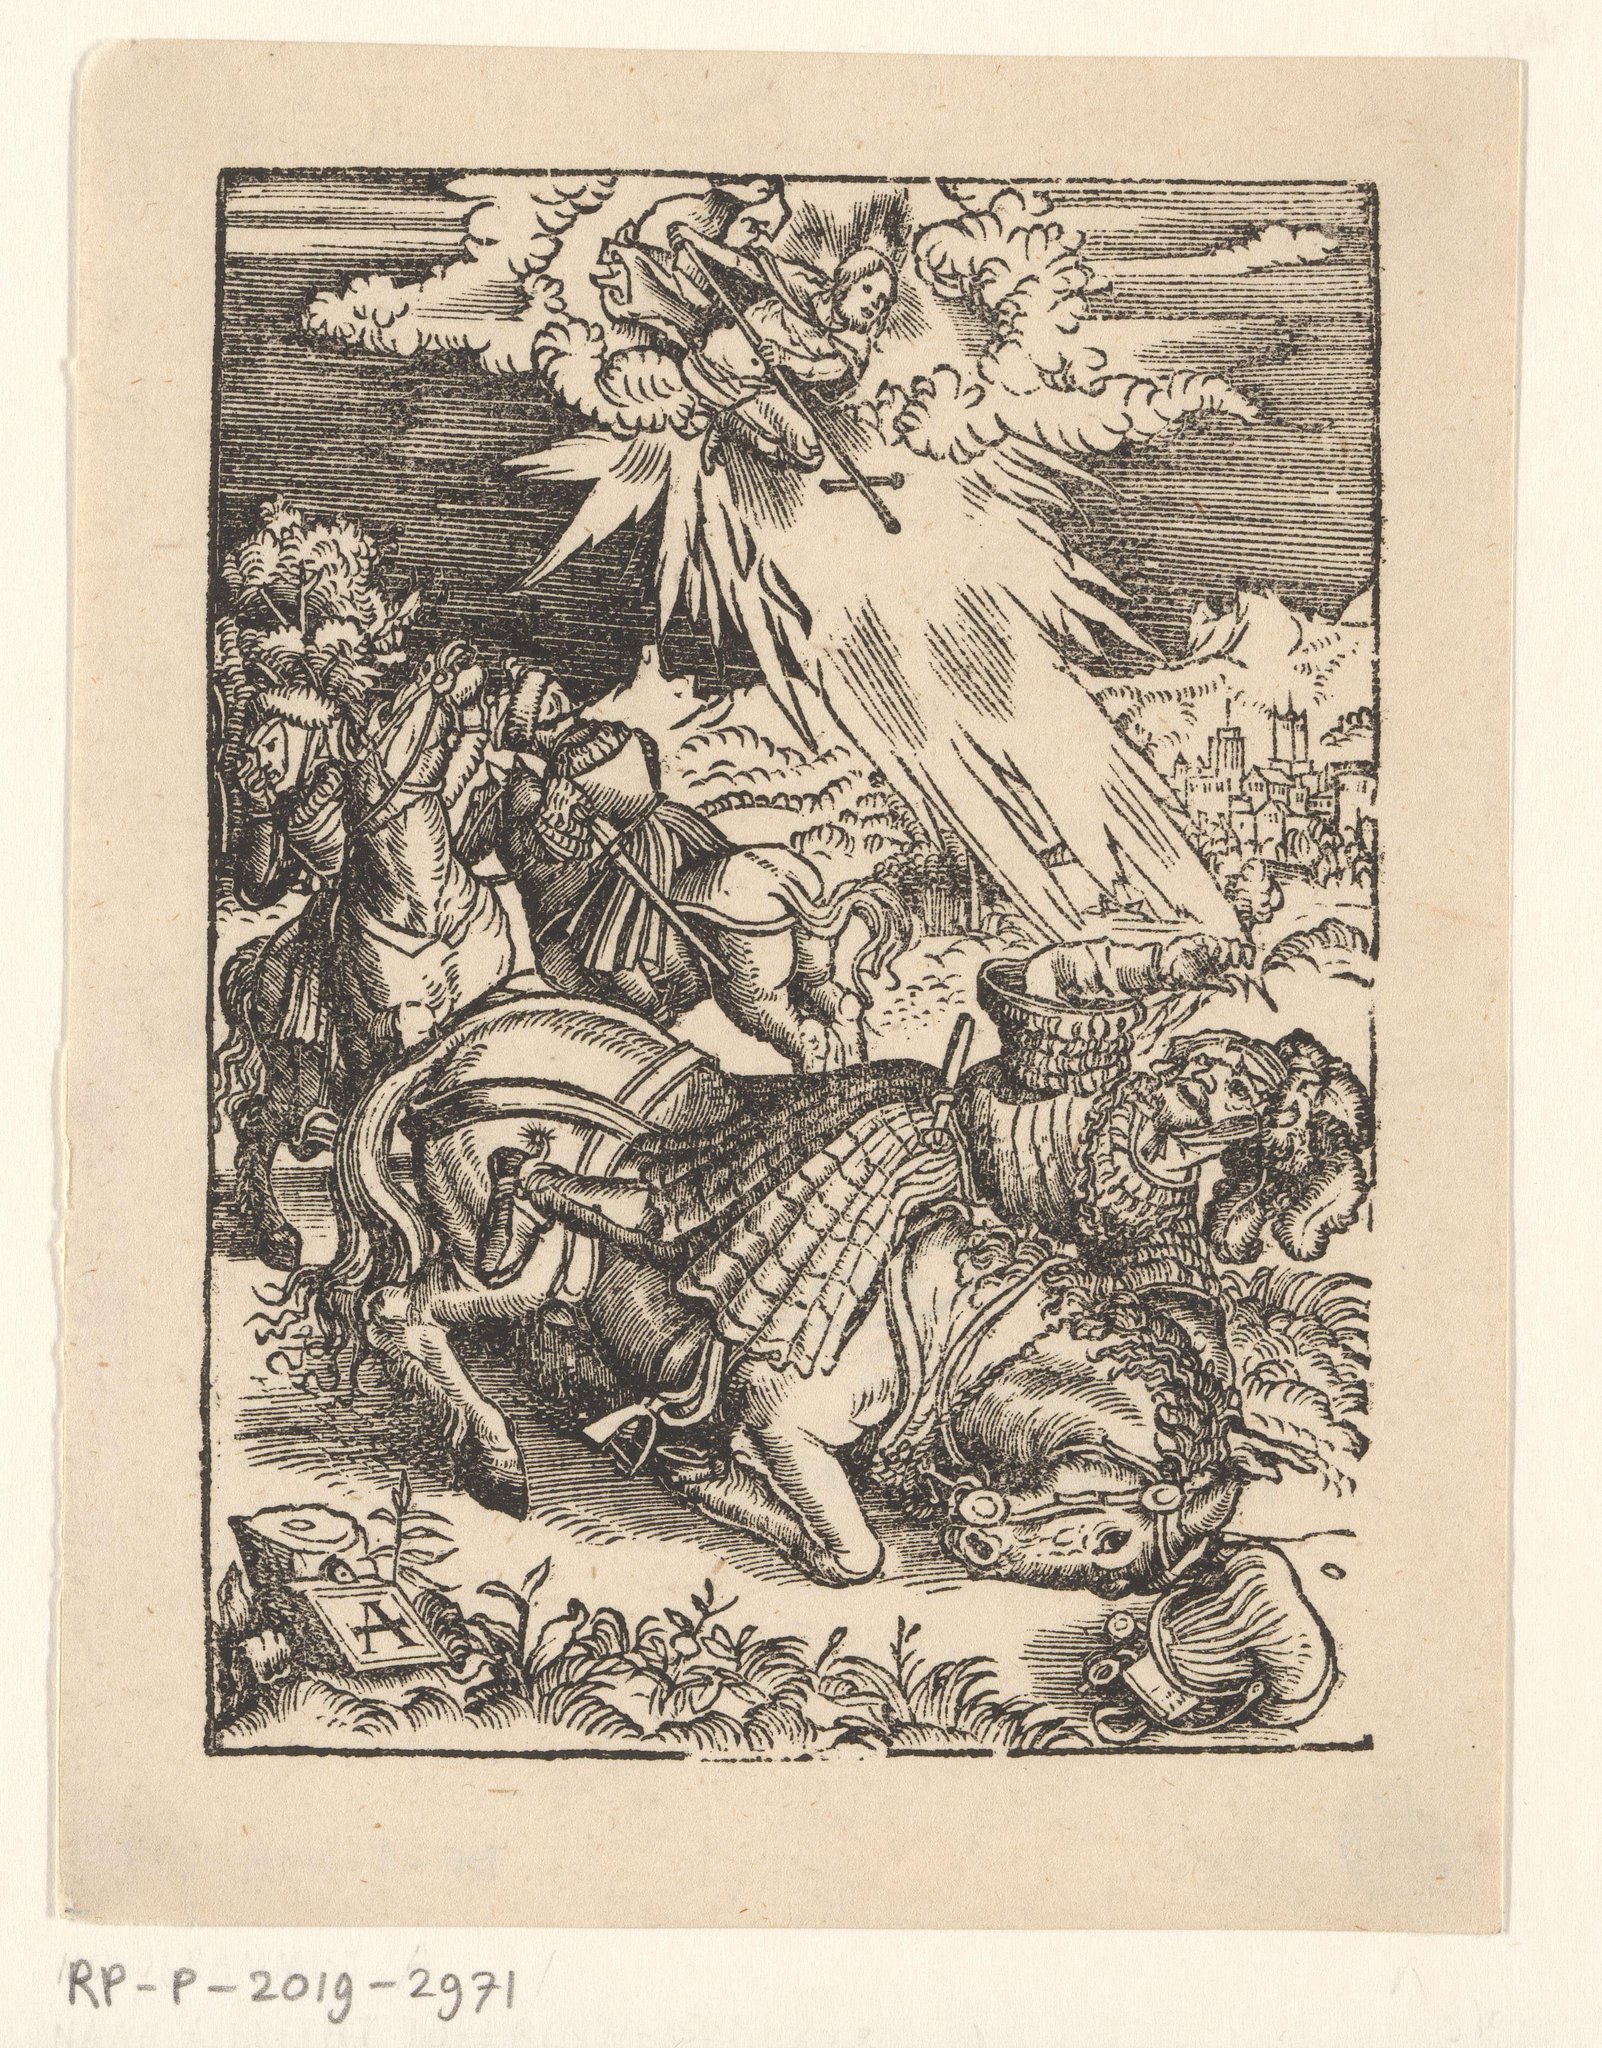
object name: print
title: Bekering van Paulus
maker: monogrammist a (16e eeuw)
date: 1500-1599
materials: paper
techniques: woodcut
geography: germany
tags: on the way to damascus christ appears to saul, who falls from his horse and is blinded by the light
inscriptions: collector's mark: Lugt 2228, collector's mark: Lugt 567